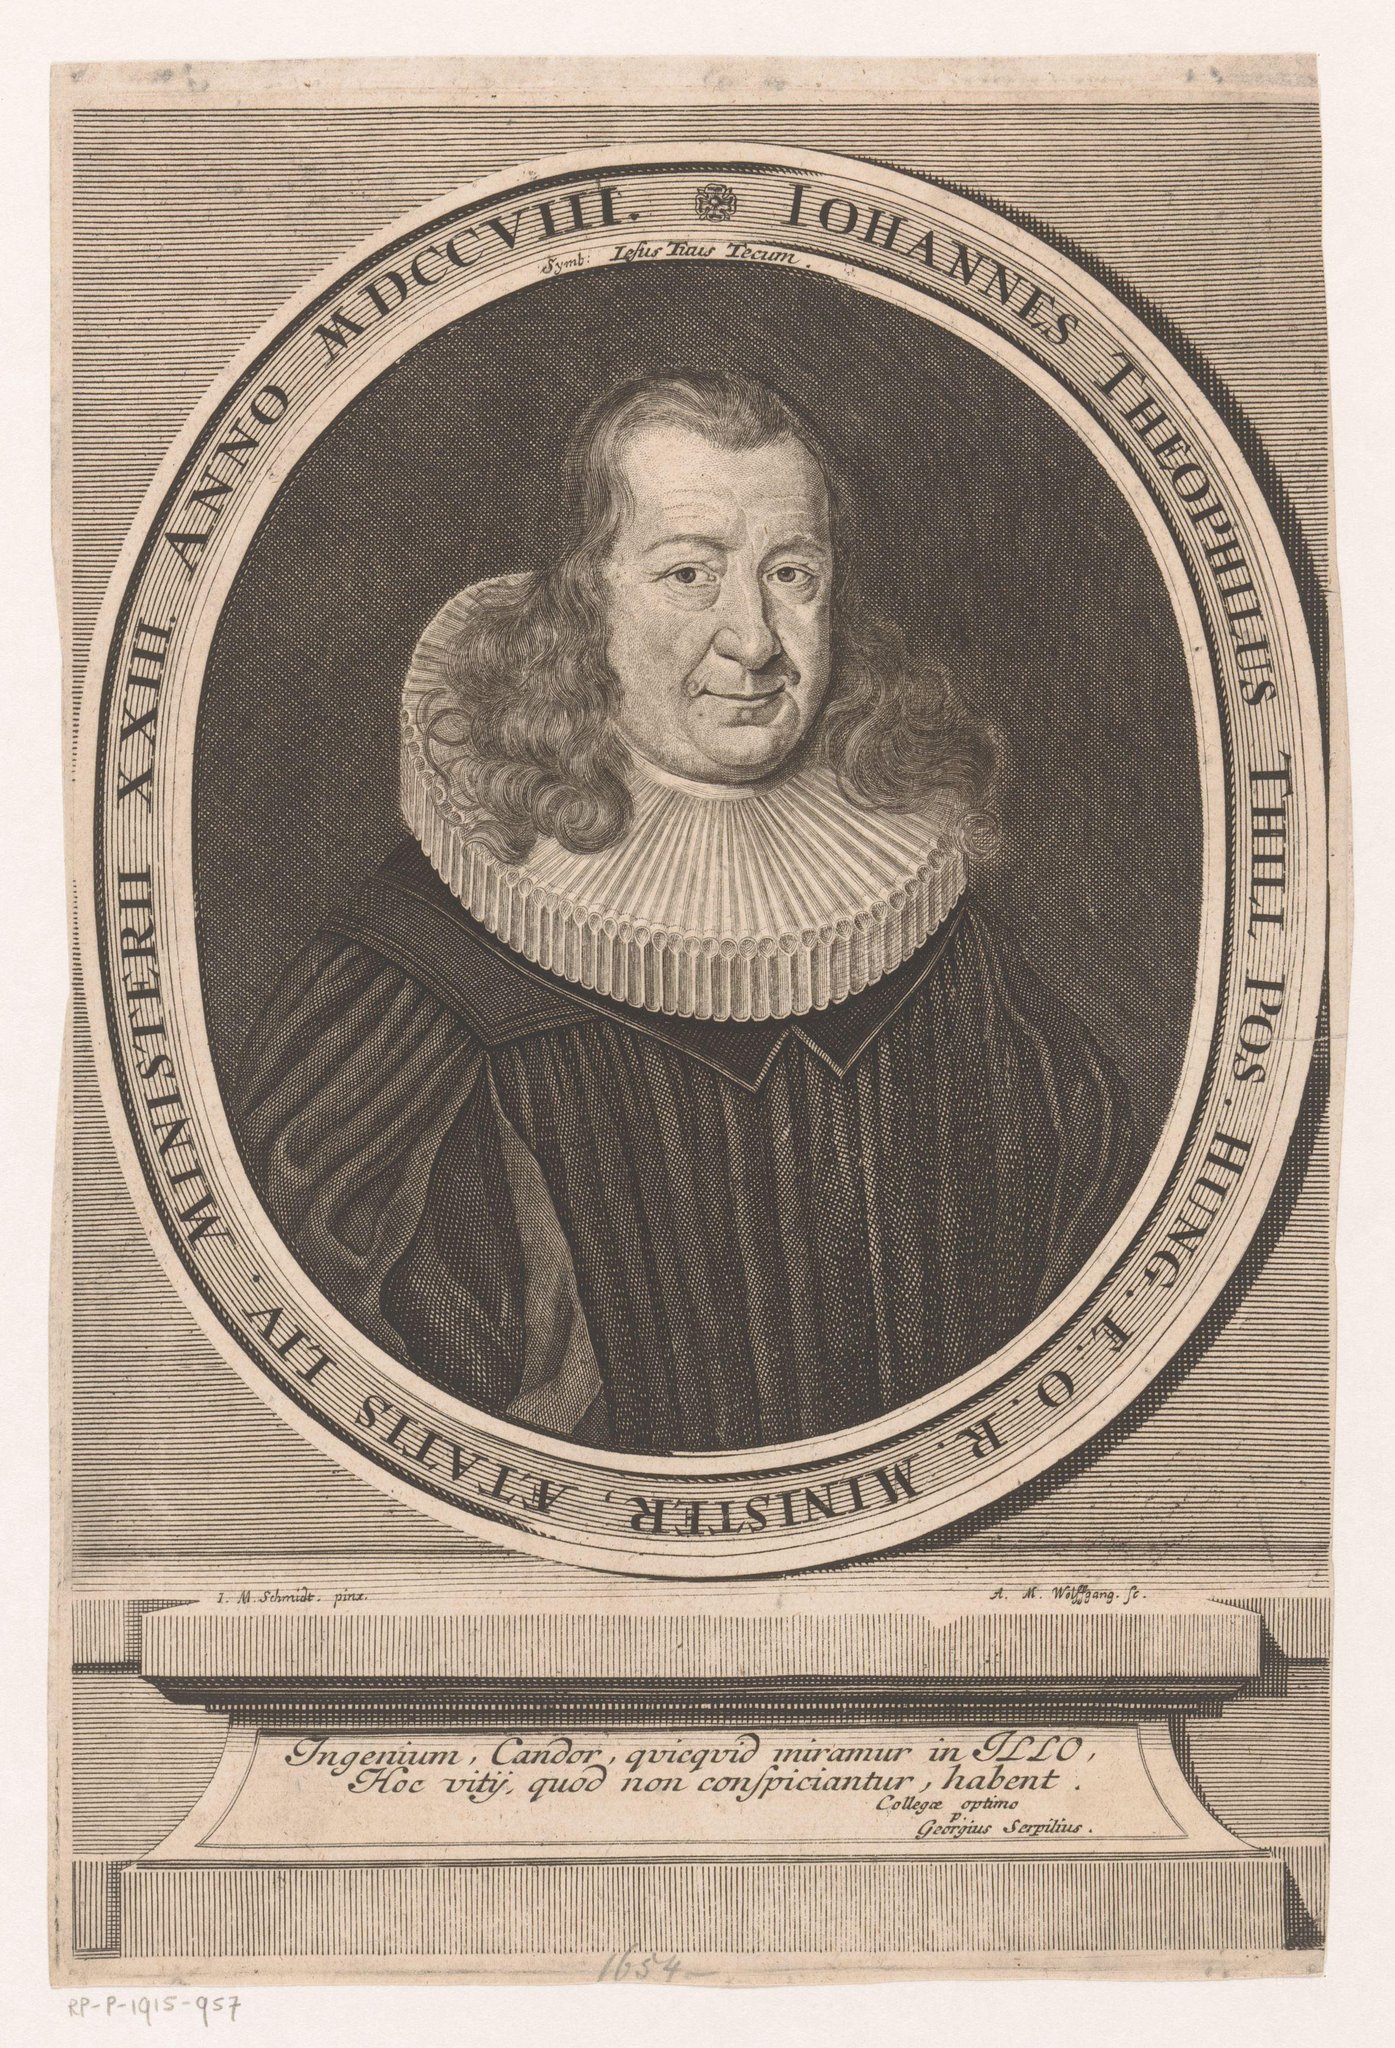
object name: print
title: Portret van Johann Gottlieb Thill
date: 1678-1737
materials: paper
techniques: engraving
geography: germany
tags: historical persons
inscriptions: collector's mark: Lugt 2228